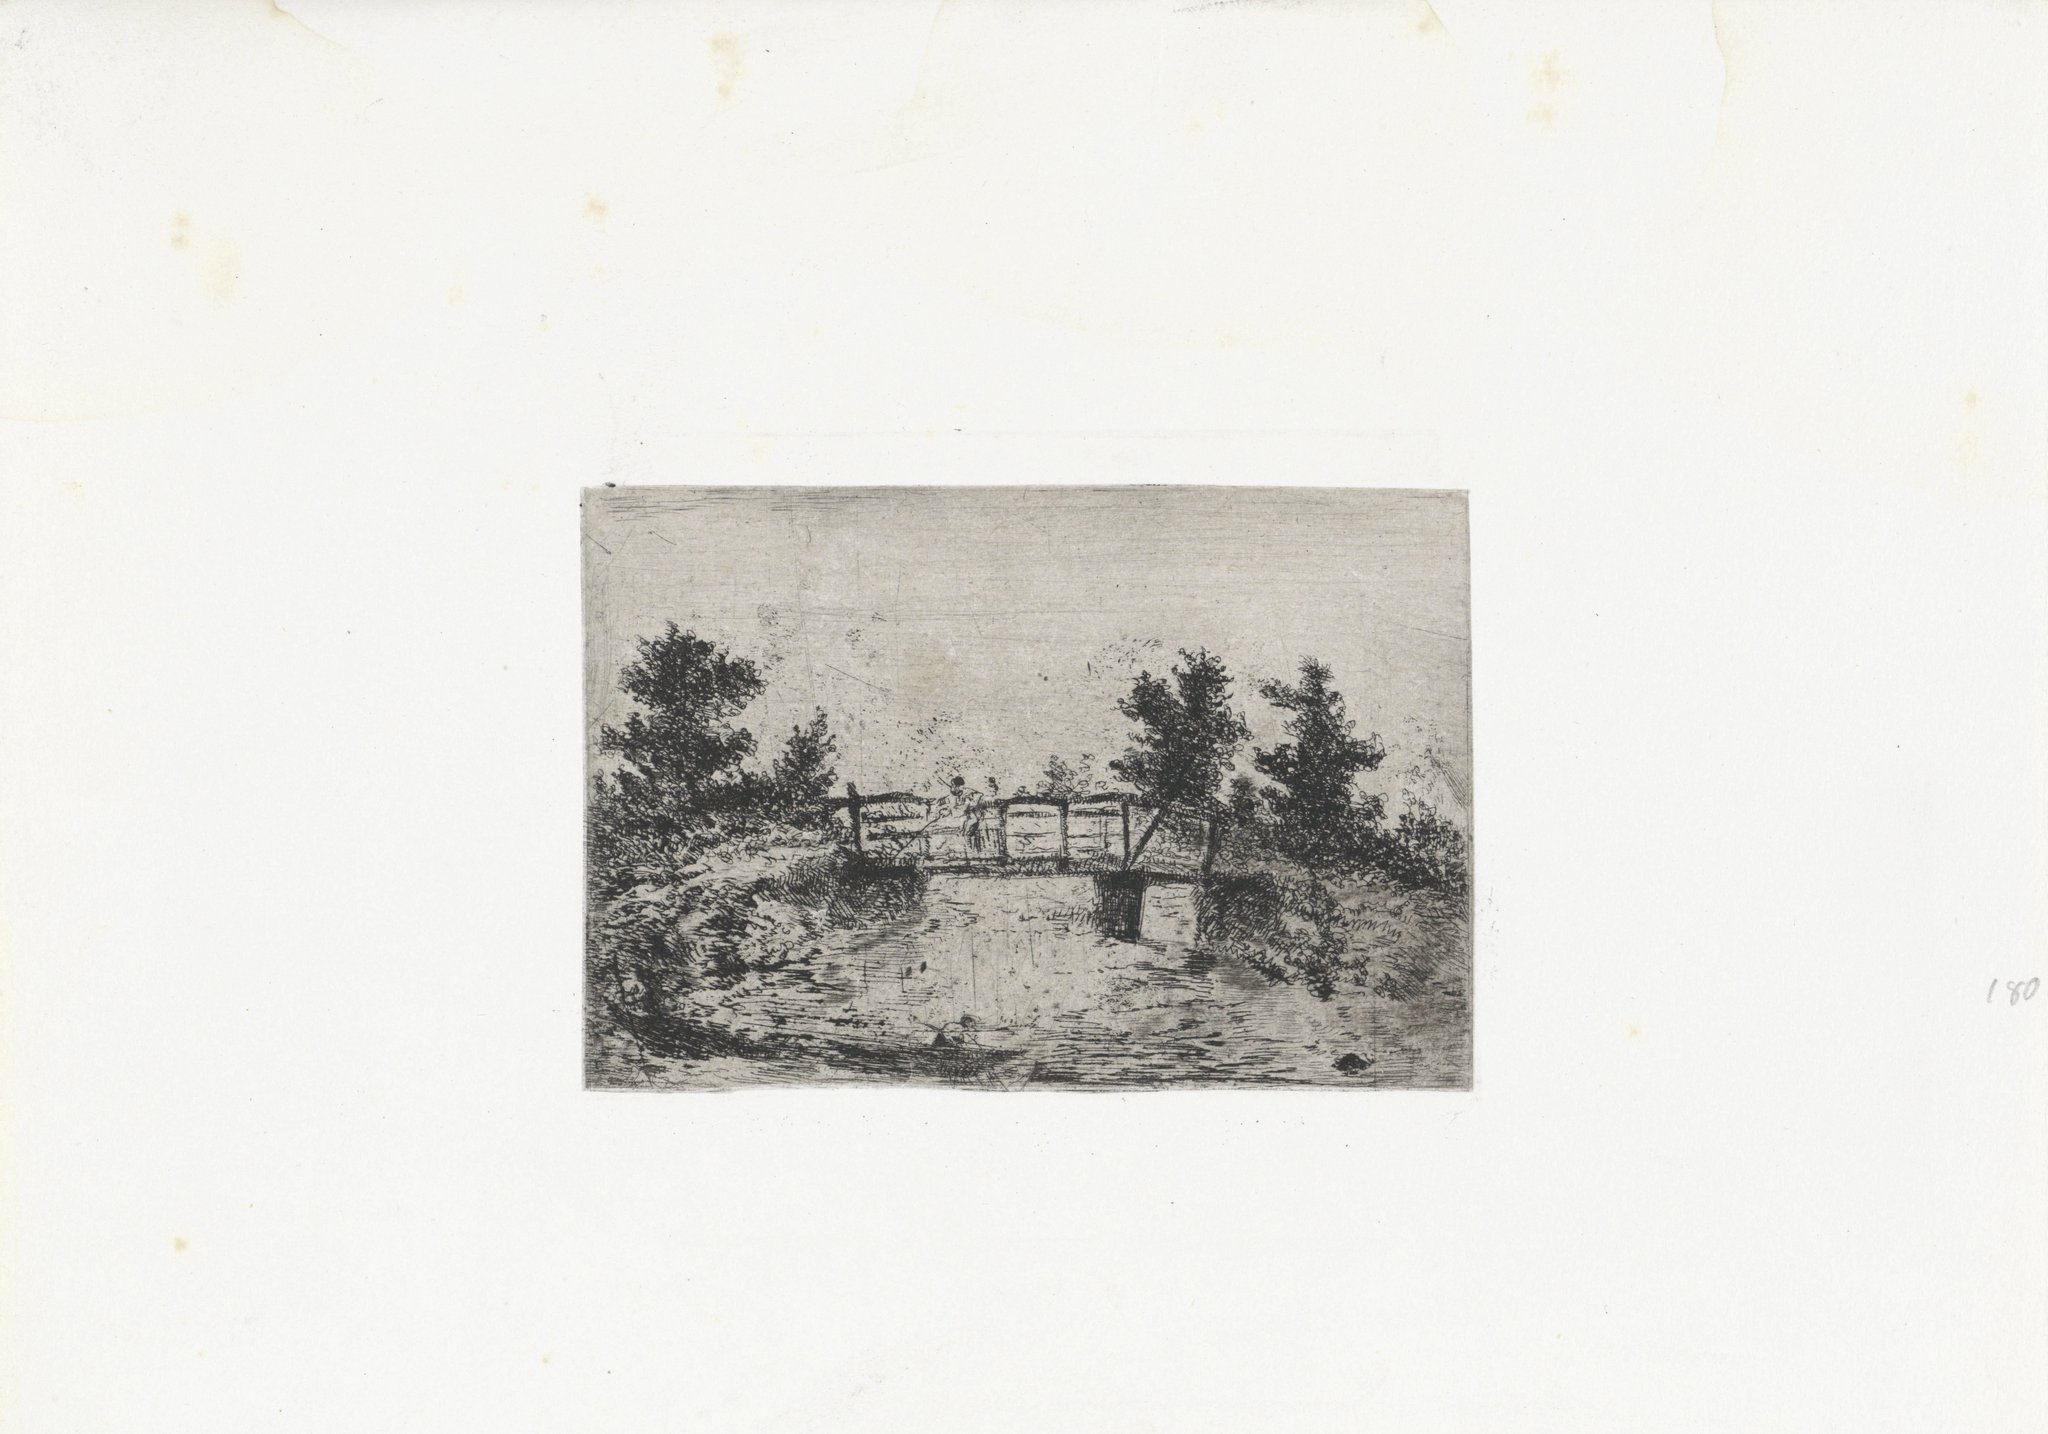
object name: print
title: Landschap met visser op een brug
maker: arnoud schaepkens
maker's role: print maker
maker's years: 1816-1904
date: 1831-1904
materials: paper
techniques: drypoint, etching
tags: fisherman (+ out of doors (sports ~ animals)), bridge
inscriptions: collector's mark: Lugt 2228